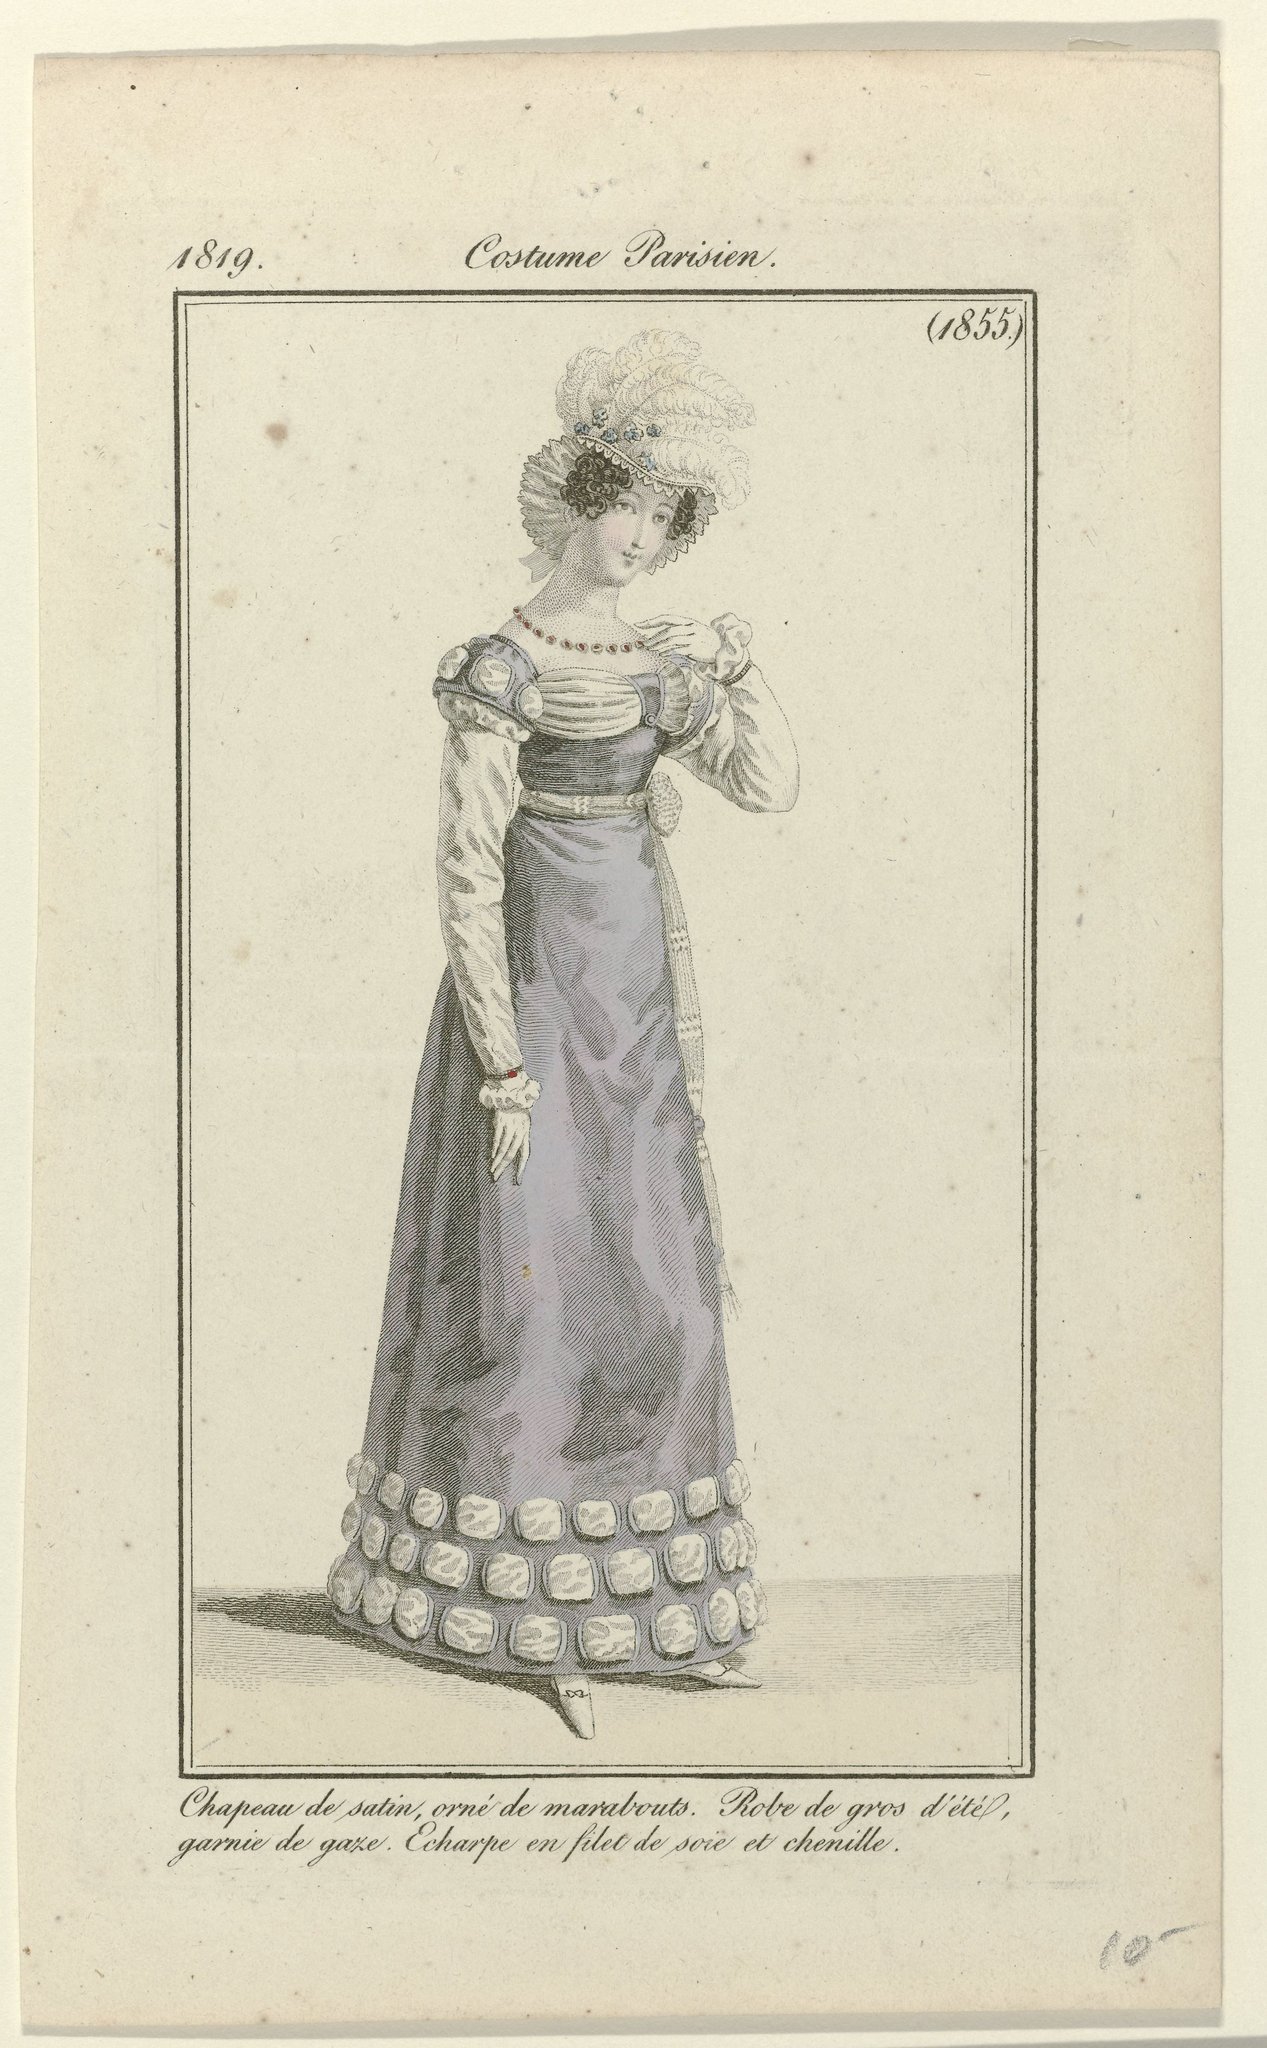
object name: fashion print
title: Journal des Dames et des Modes, Costume Parisien, 5 novembre 1819, (1855): Chapeau de satin (...)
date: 1819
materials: paper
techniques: engraving, hand coloring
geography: paris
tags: ornamental parts of clothing (+ women's clothes), fashion plates, head-gear: hat (+ women's clothes), shoes, sandals (+ women's clothes), dress, gown (+ women's clothes), bracelet, wristlet (+ women's clothes), necklace (+ women's clothes), belt, girdle, waistband (+ women's clothes)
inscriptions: title: ‘Costume Parisien.’, caption: ‘Chapeau de satin, orné de marabouts. Robe de gros d'été, garnie de gaze. Echarpe en filet de soie et chenille.’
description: Staande vrouw met op het hoofd een hoed van satijn, versierd met maraboeveren. Zij draagt een japon van 'gros d'été', afgezet met tule. Om het middel een sjerp van 'filet de soie' en chenille. Verdere accessoires: collier, om beide polsen armbanden, platte schoenen met strikken. De prent maakt deel uit van het modetijdschrift Journal des Dames et des Modes, uitgegeven door Pierre de la Mésangère, Parijs, 1797-1839.